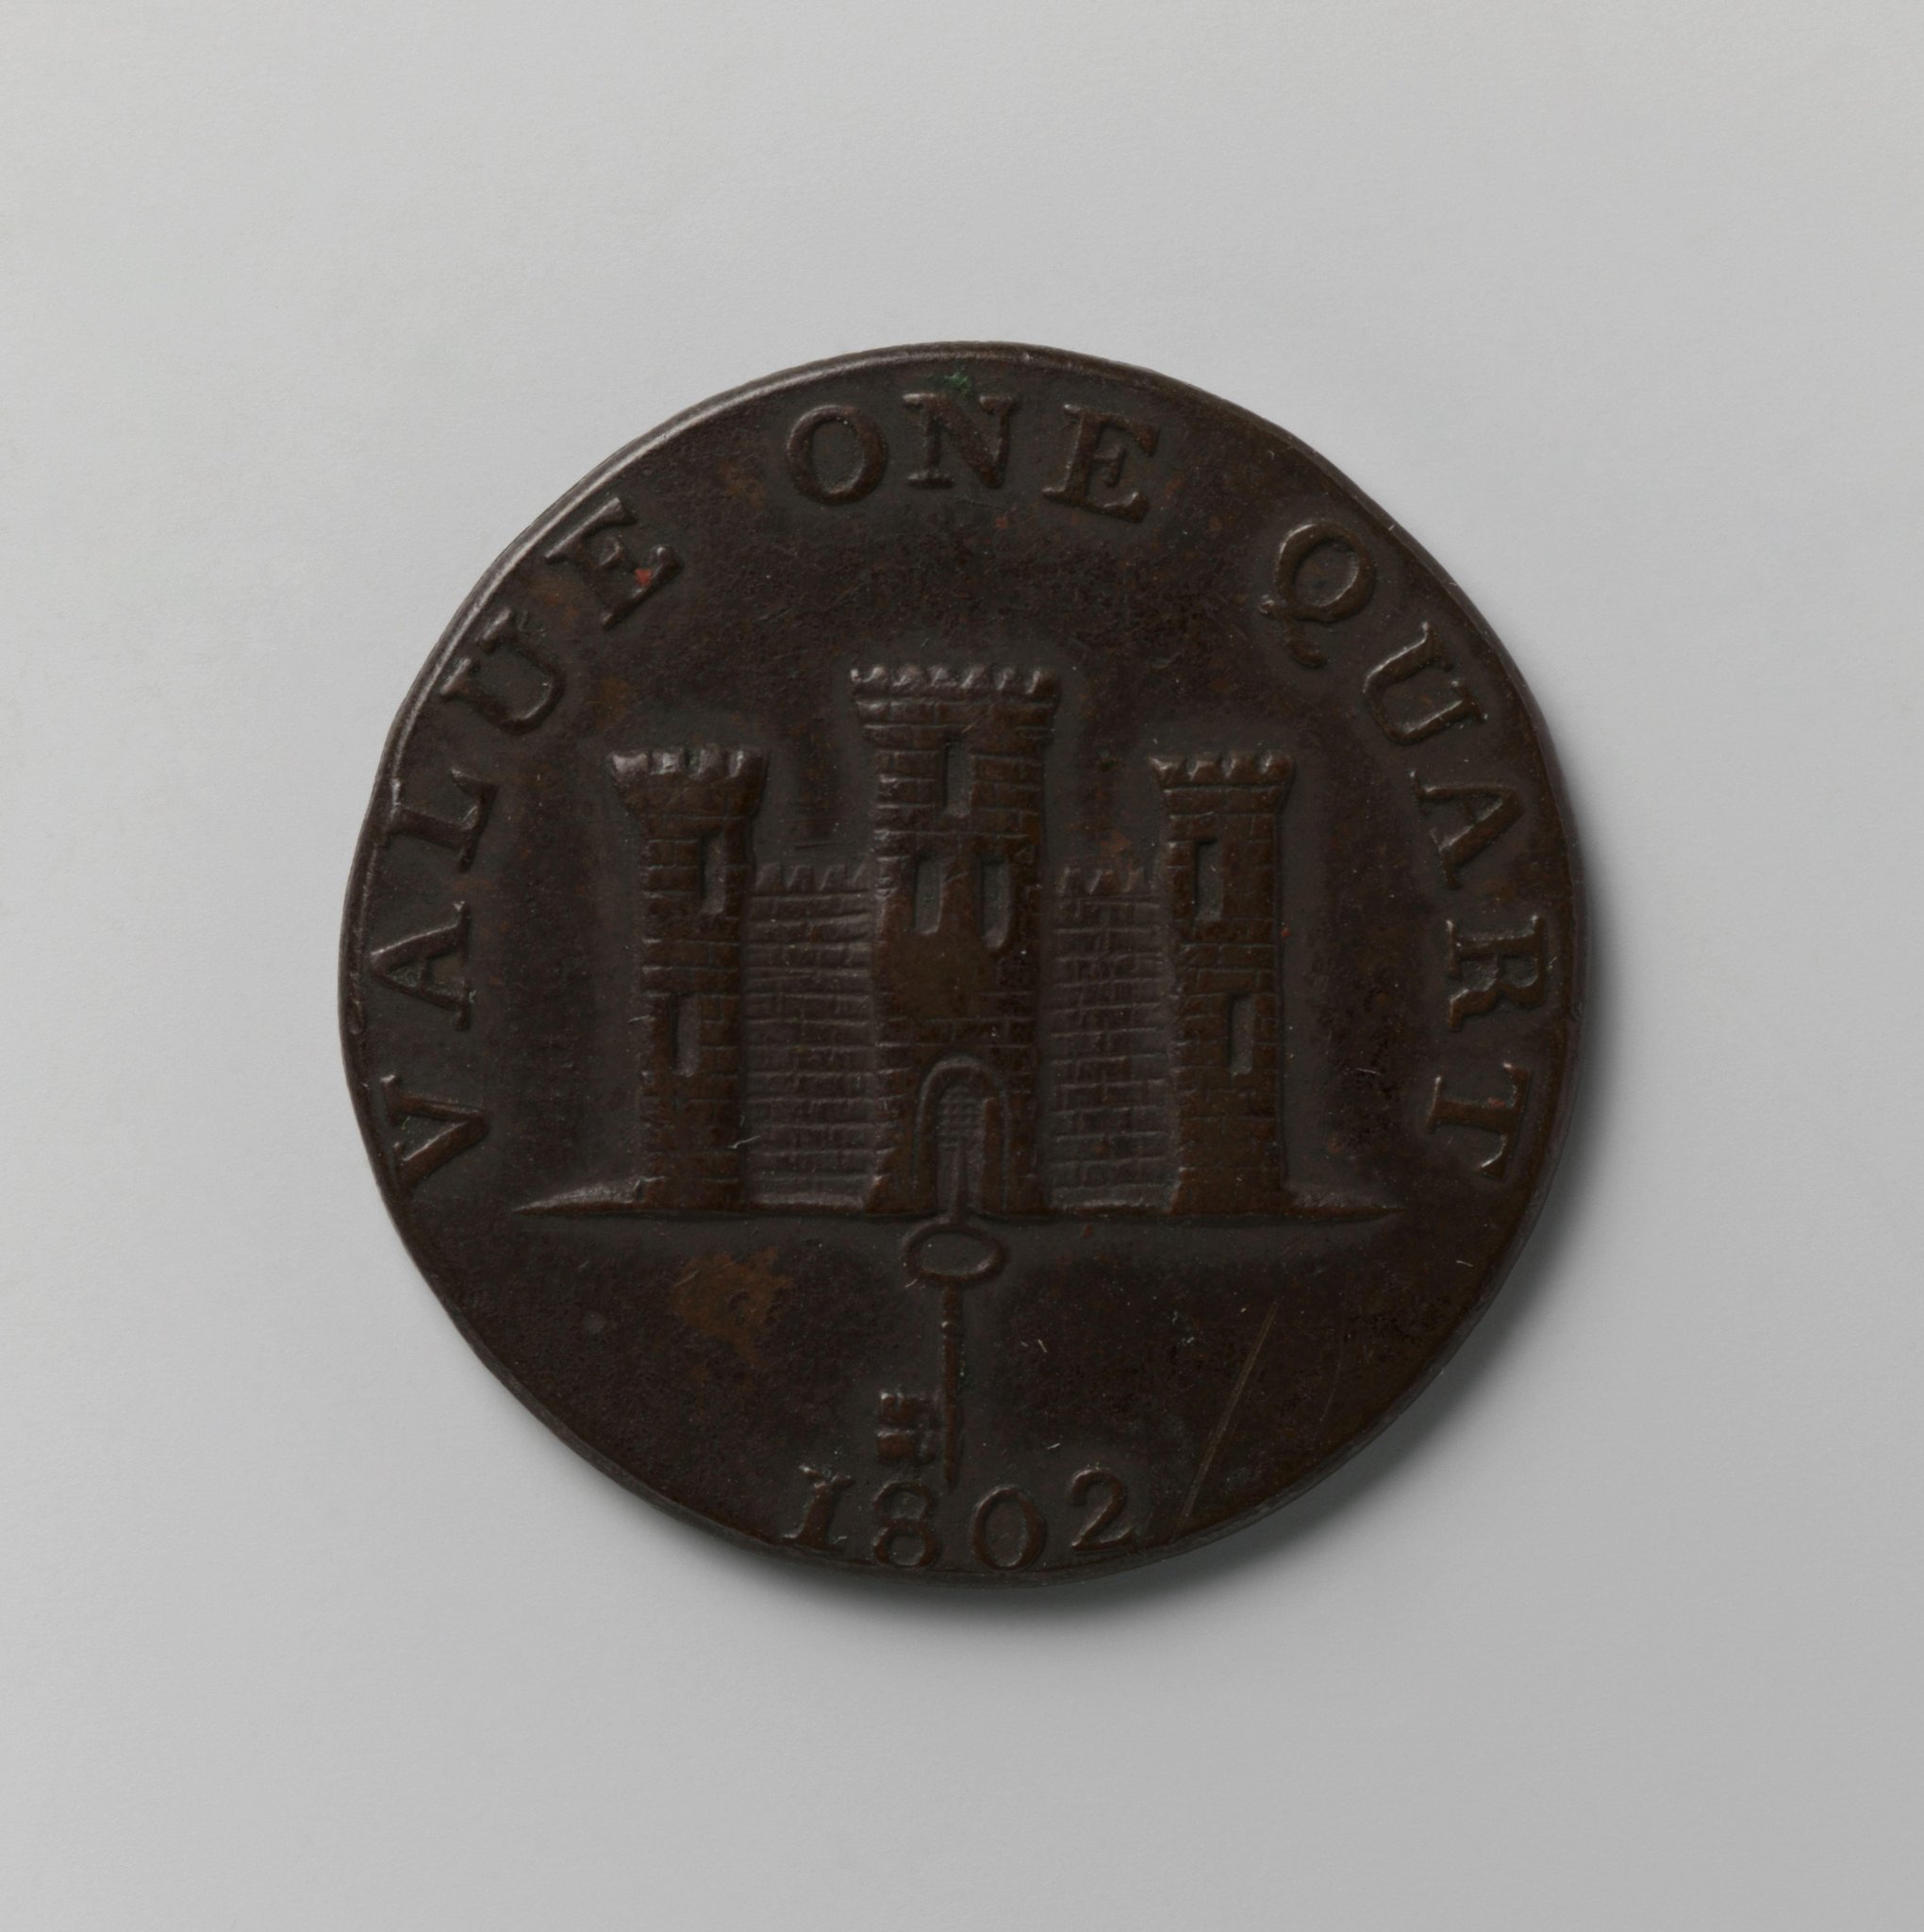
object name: coin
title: Gibraltar, quart, 1802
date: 1802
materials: copper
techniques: striking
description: Koperen particuliere munt. Voorzijde: zicht vanuit zee op Gibraltar. Keerzijde: kasteel, waaronder sleutel. Daaronder jaartal. Waarde-aanduiding in omschrft. Gladde rand.